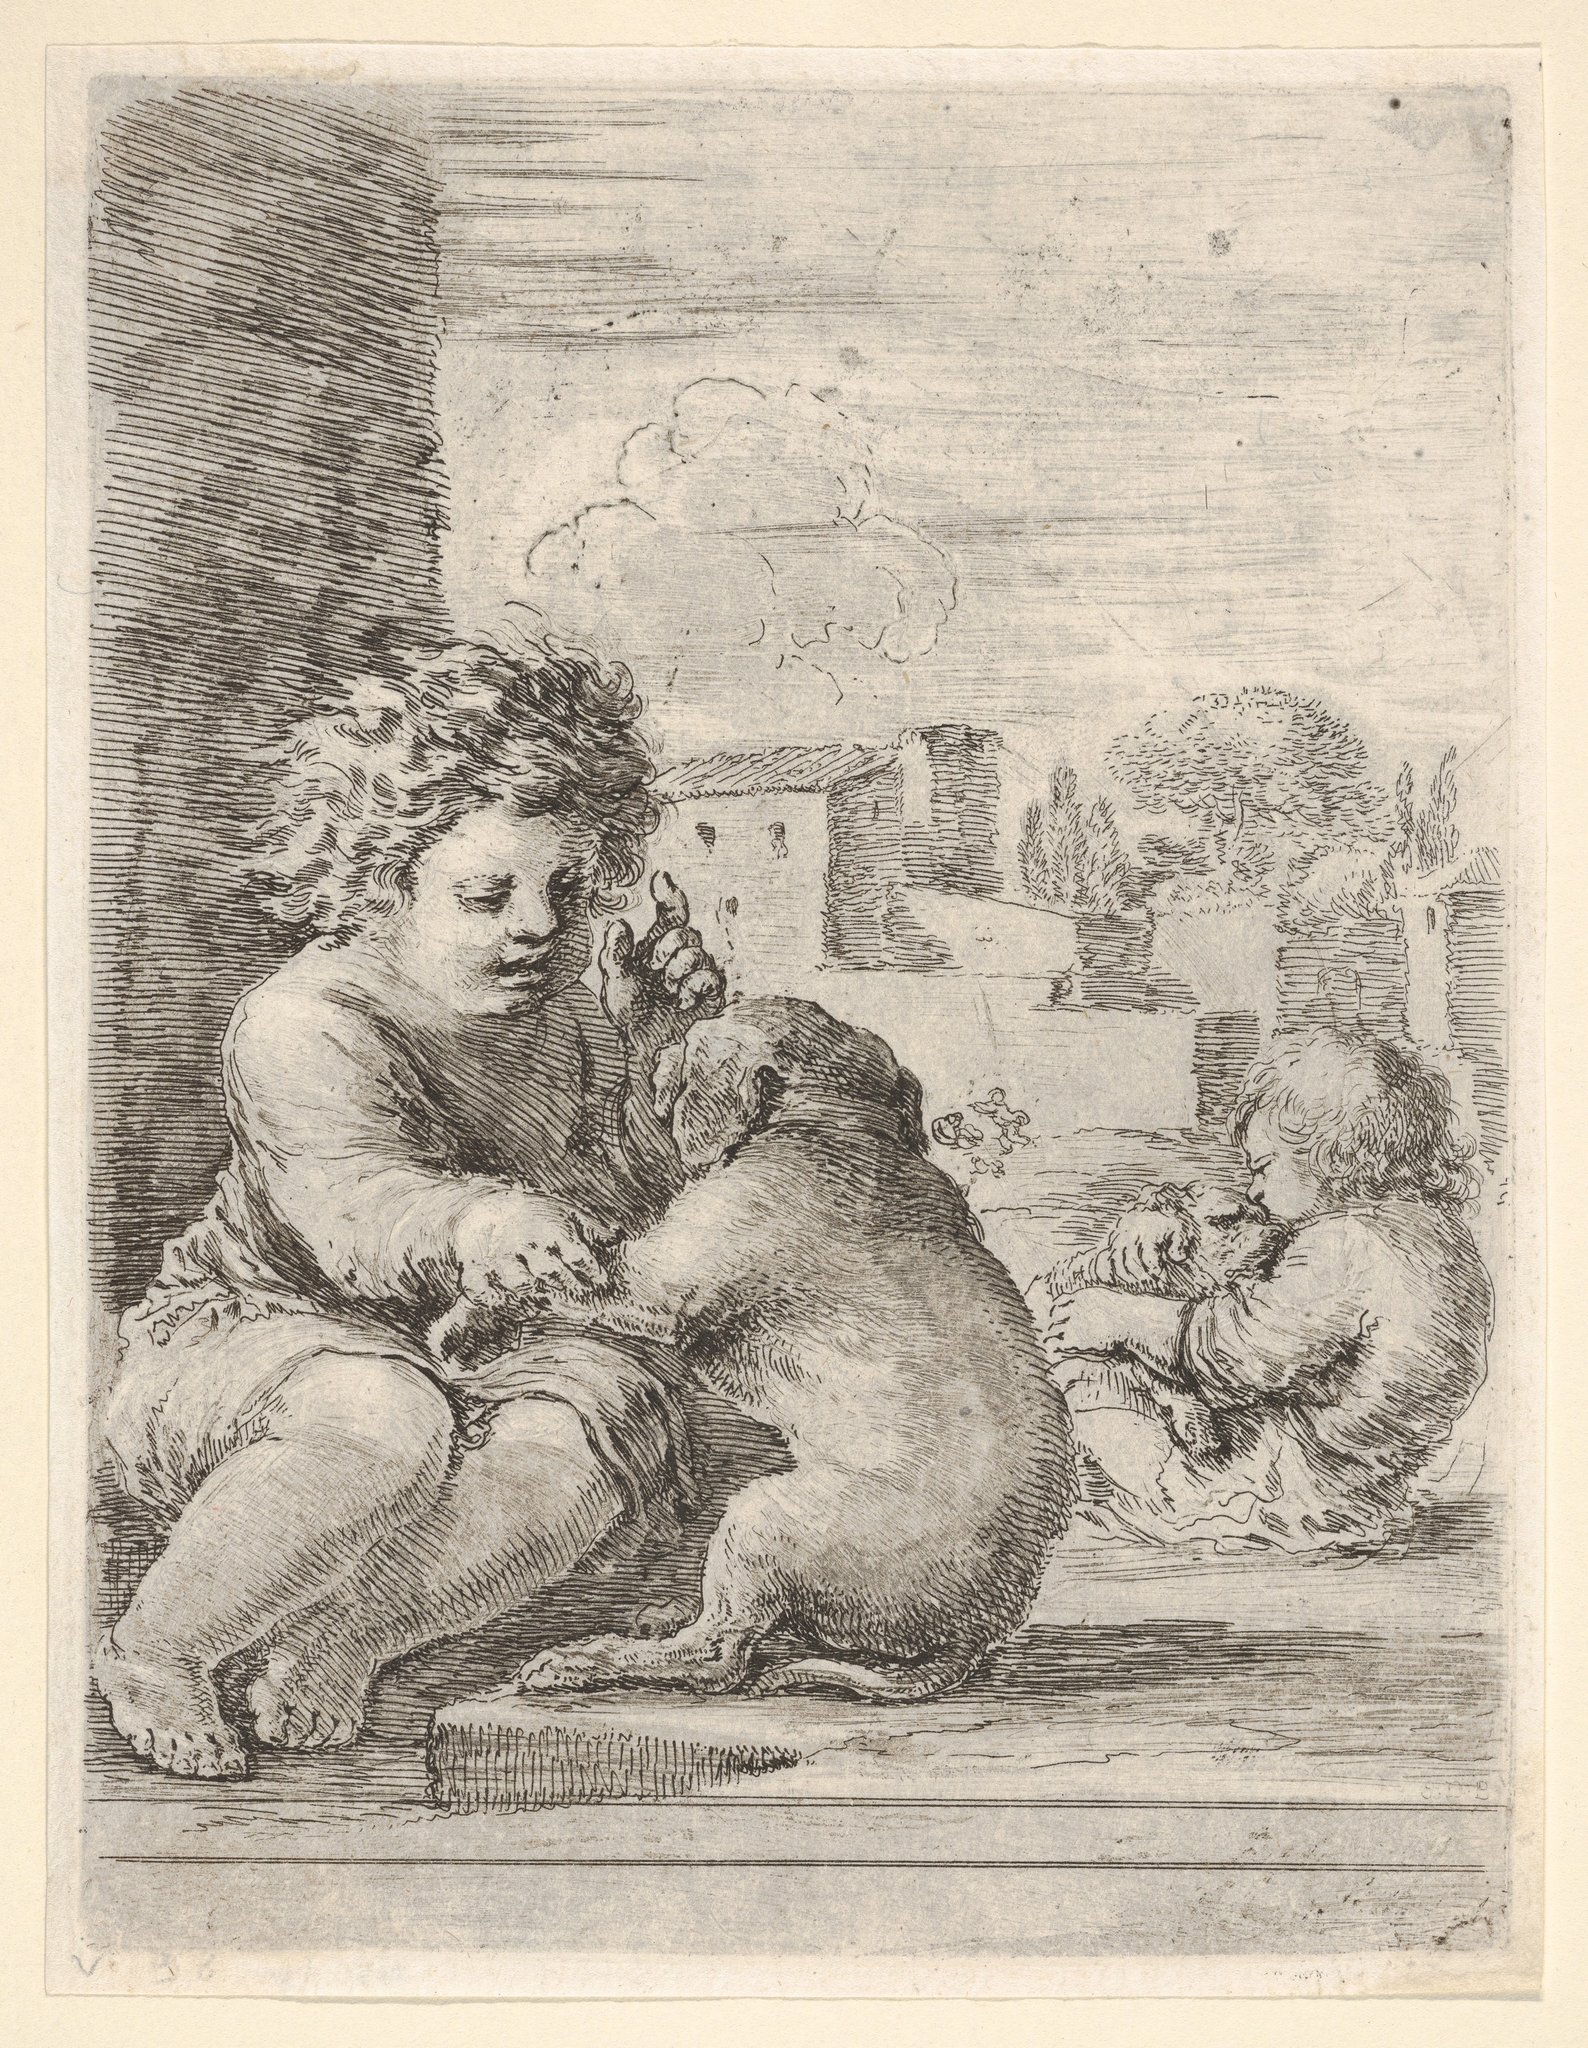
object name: print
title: Child teaching a dog to sit, the child seated to left against a wall, teaching the dog to sit on its hind legs, another child embracing a dog to right in the background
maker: stefano della bella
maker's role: artist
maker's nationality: italian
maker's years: 1610-1664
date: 1660-1664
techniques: etching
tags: boys,dogs